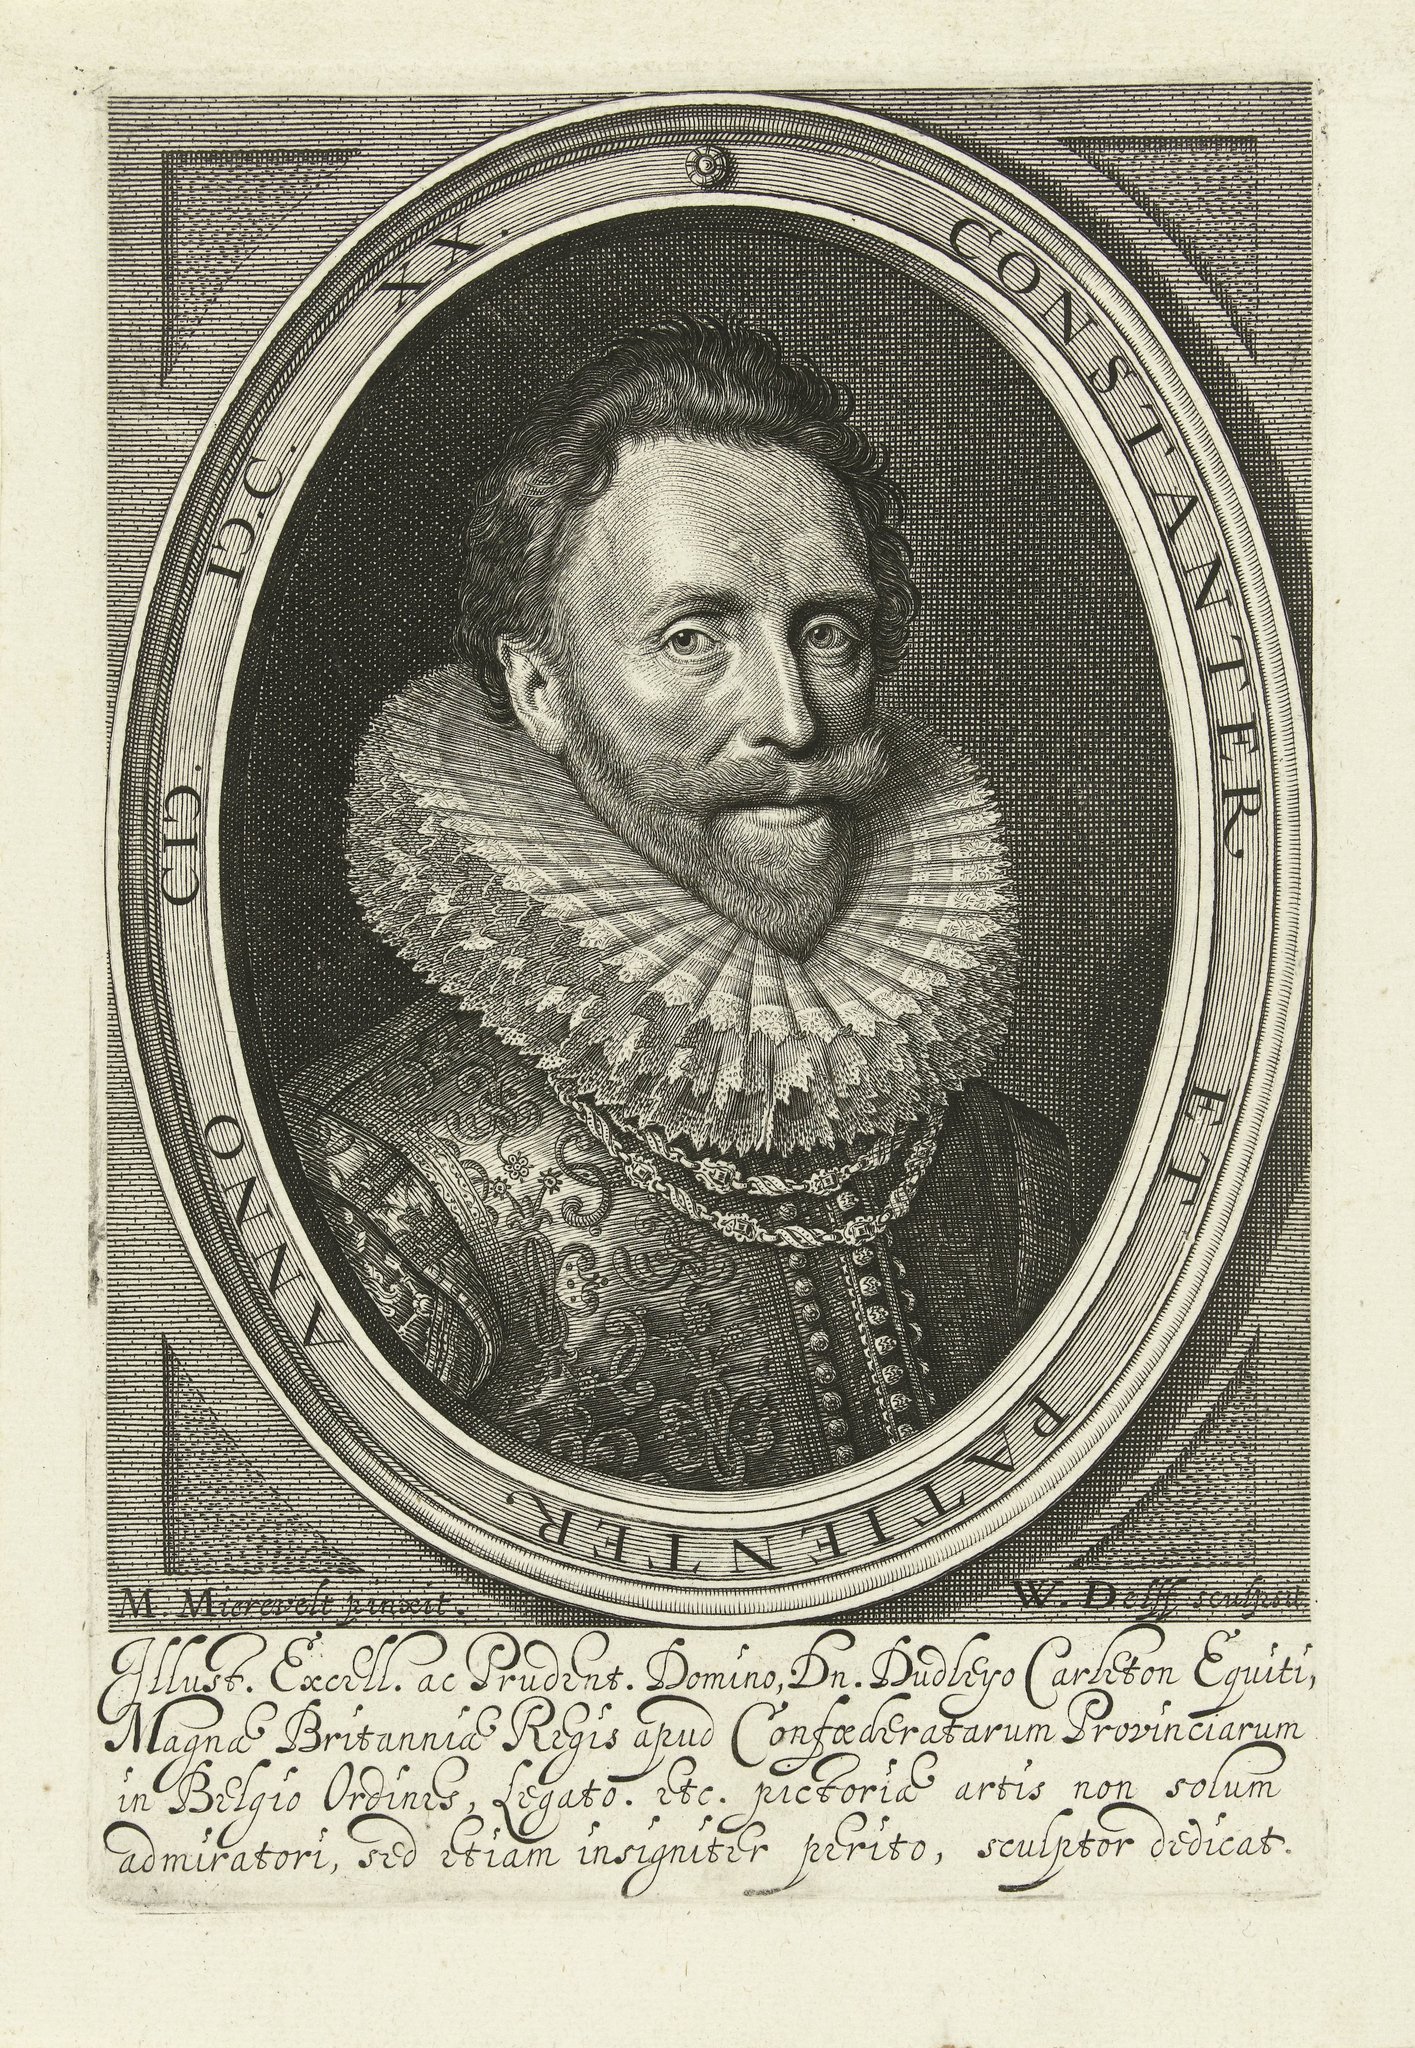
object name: print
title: Portret van Dudley Carlton, graaf van Dorchester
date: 1620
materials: paper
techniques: engraving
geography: delft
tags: dudley carlton (graaf van dorchester)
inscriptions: collector's mark: Lugt 2228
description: Portret van Dudley Carlton, graaf van Dorchester, borststuk met molenkraag in ovale omlijsting met motto, in ondermarge Latijns opschrift.